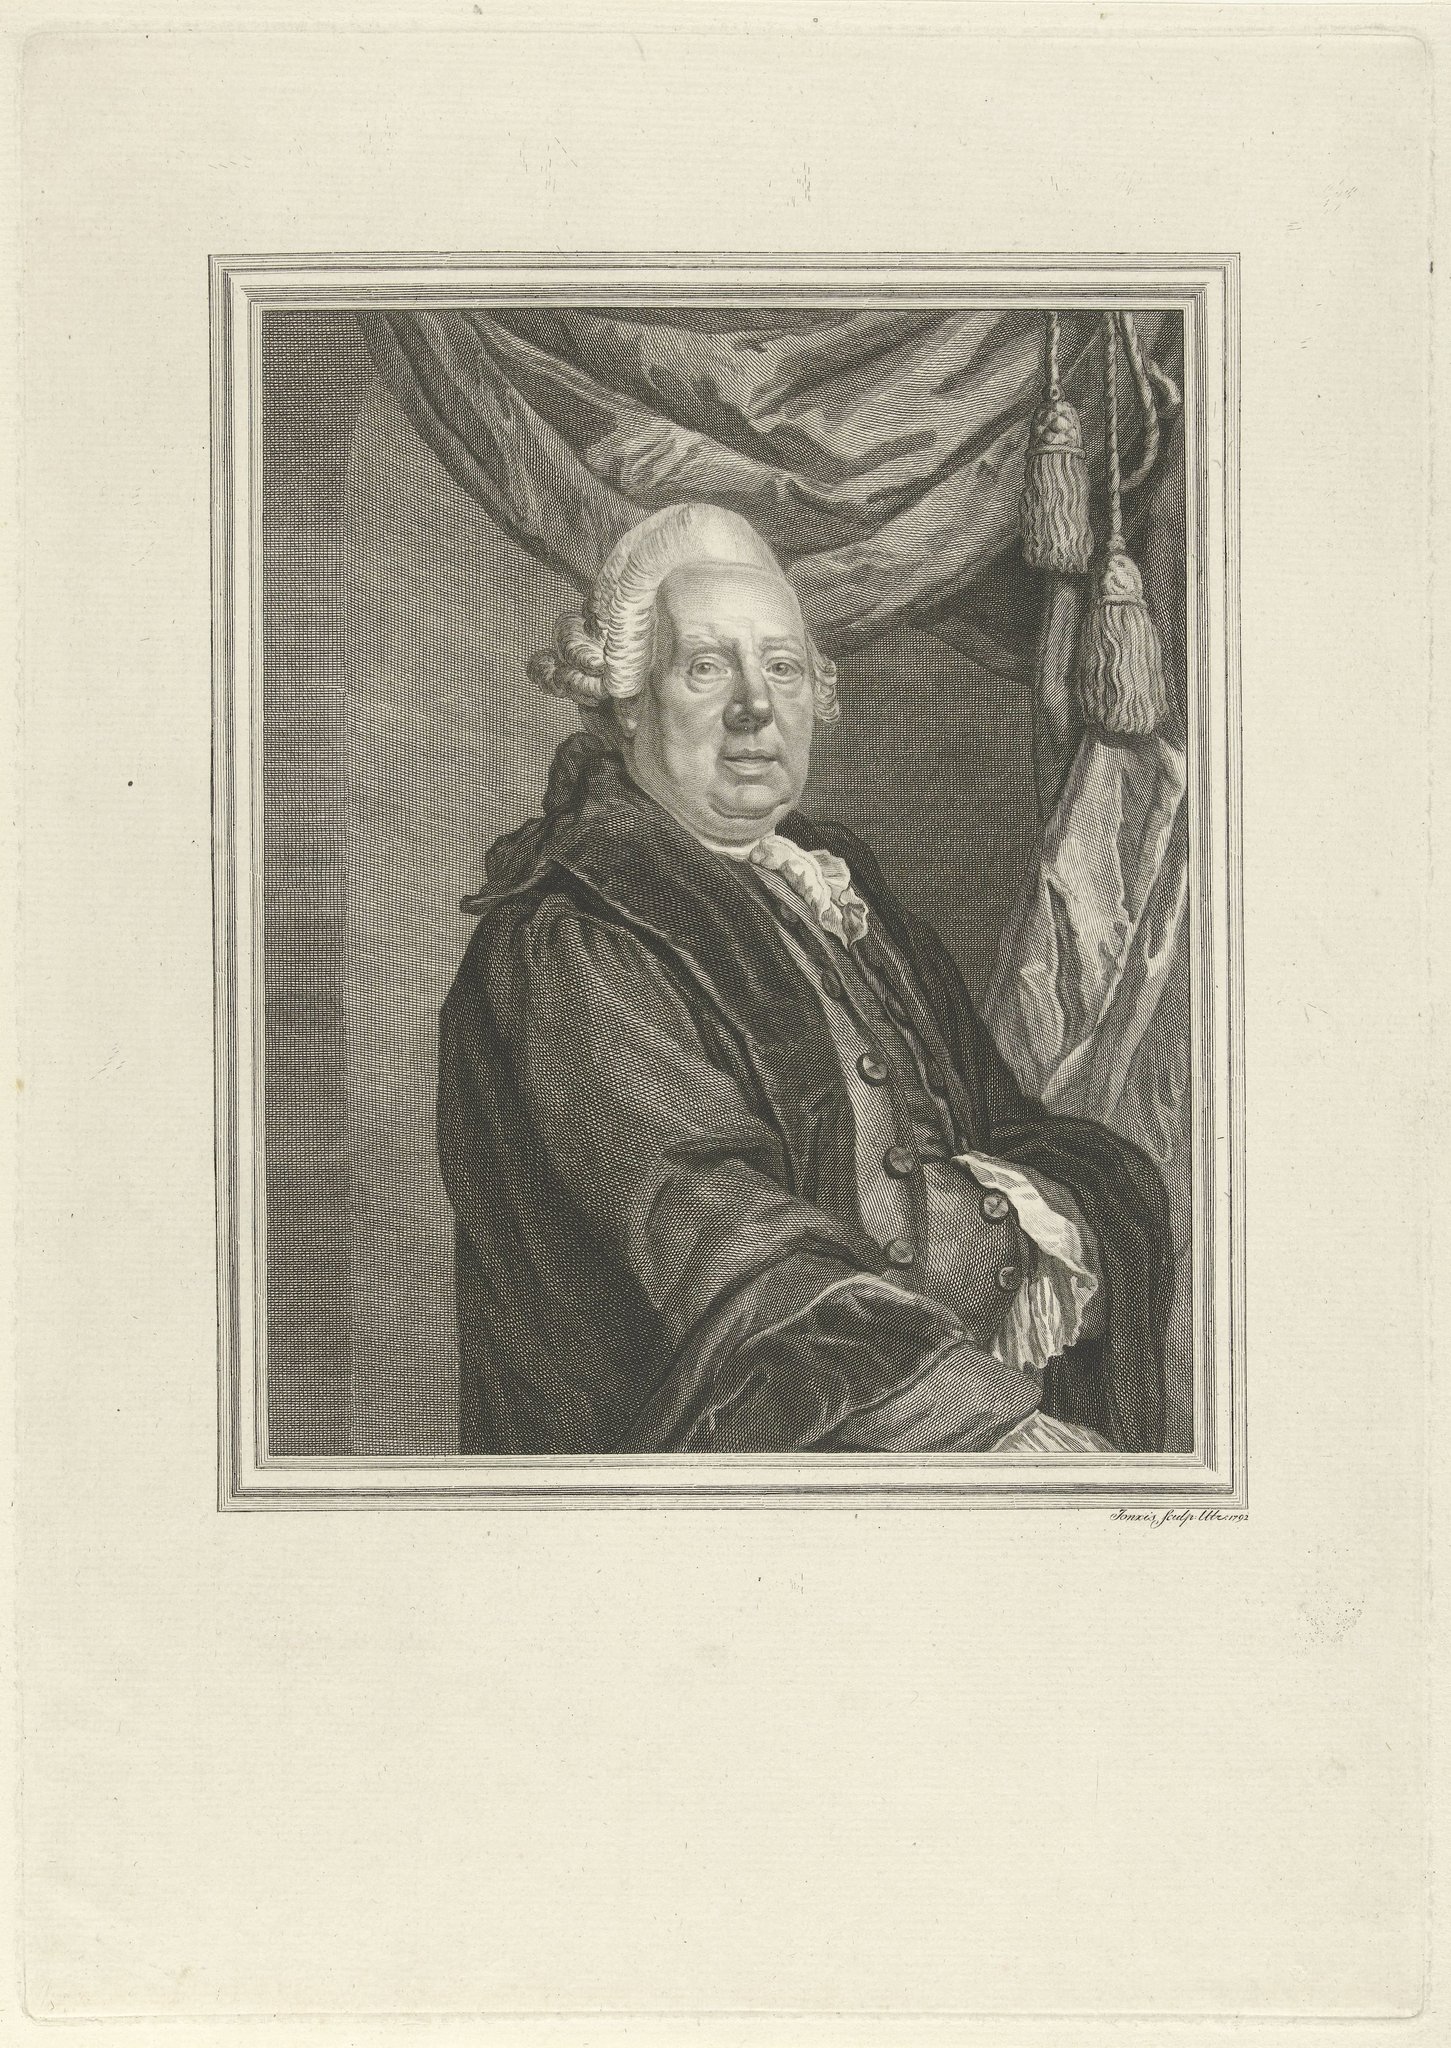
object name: print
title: Portret van David Ruhnken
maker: pieter hendrik jonxis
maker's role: print maker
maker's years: 1757-1843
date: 1792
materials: paper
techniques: engraving, etching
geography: utrecht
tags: leiden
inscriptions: collector's mark: Lugt 2228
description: Portret van de filoloog David Ruhnken, ten halven lijve. Hij staat bij een gordijn en heeft zijn linkerhand in zijn toga gestoken. Met een lege marge.